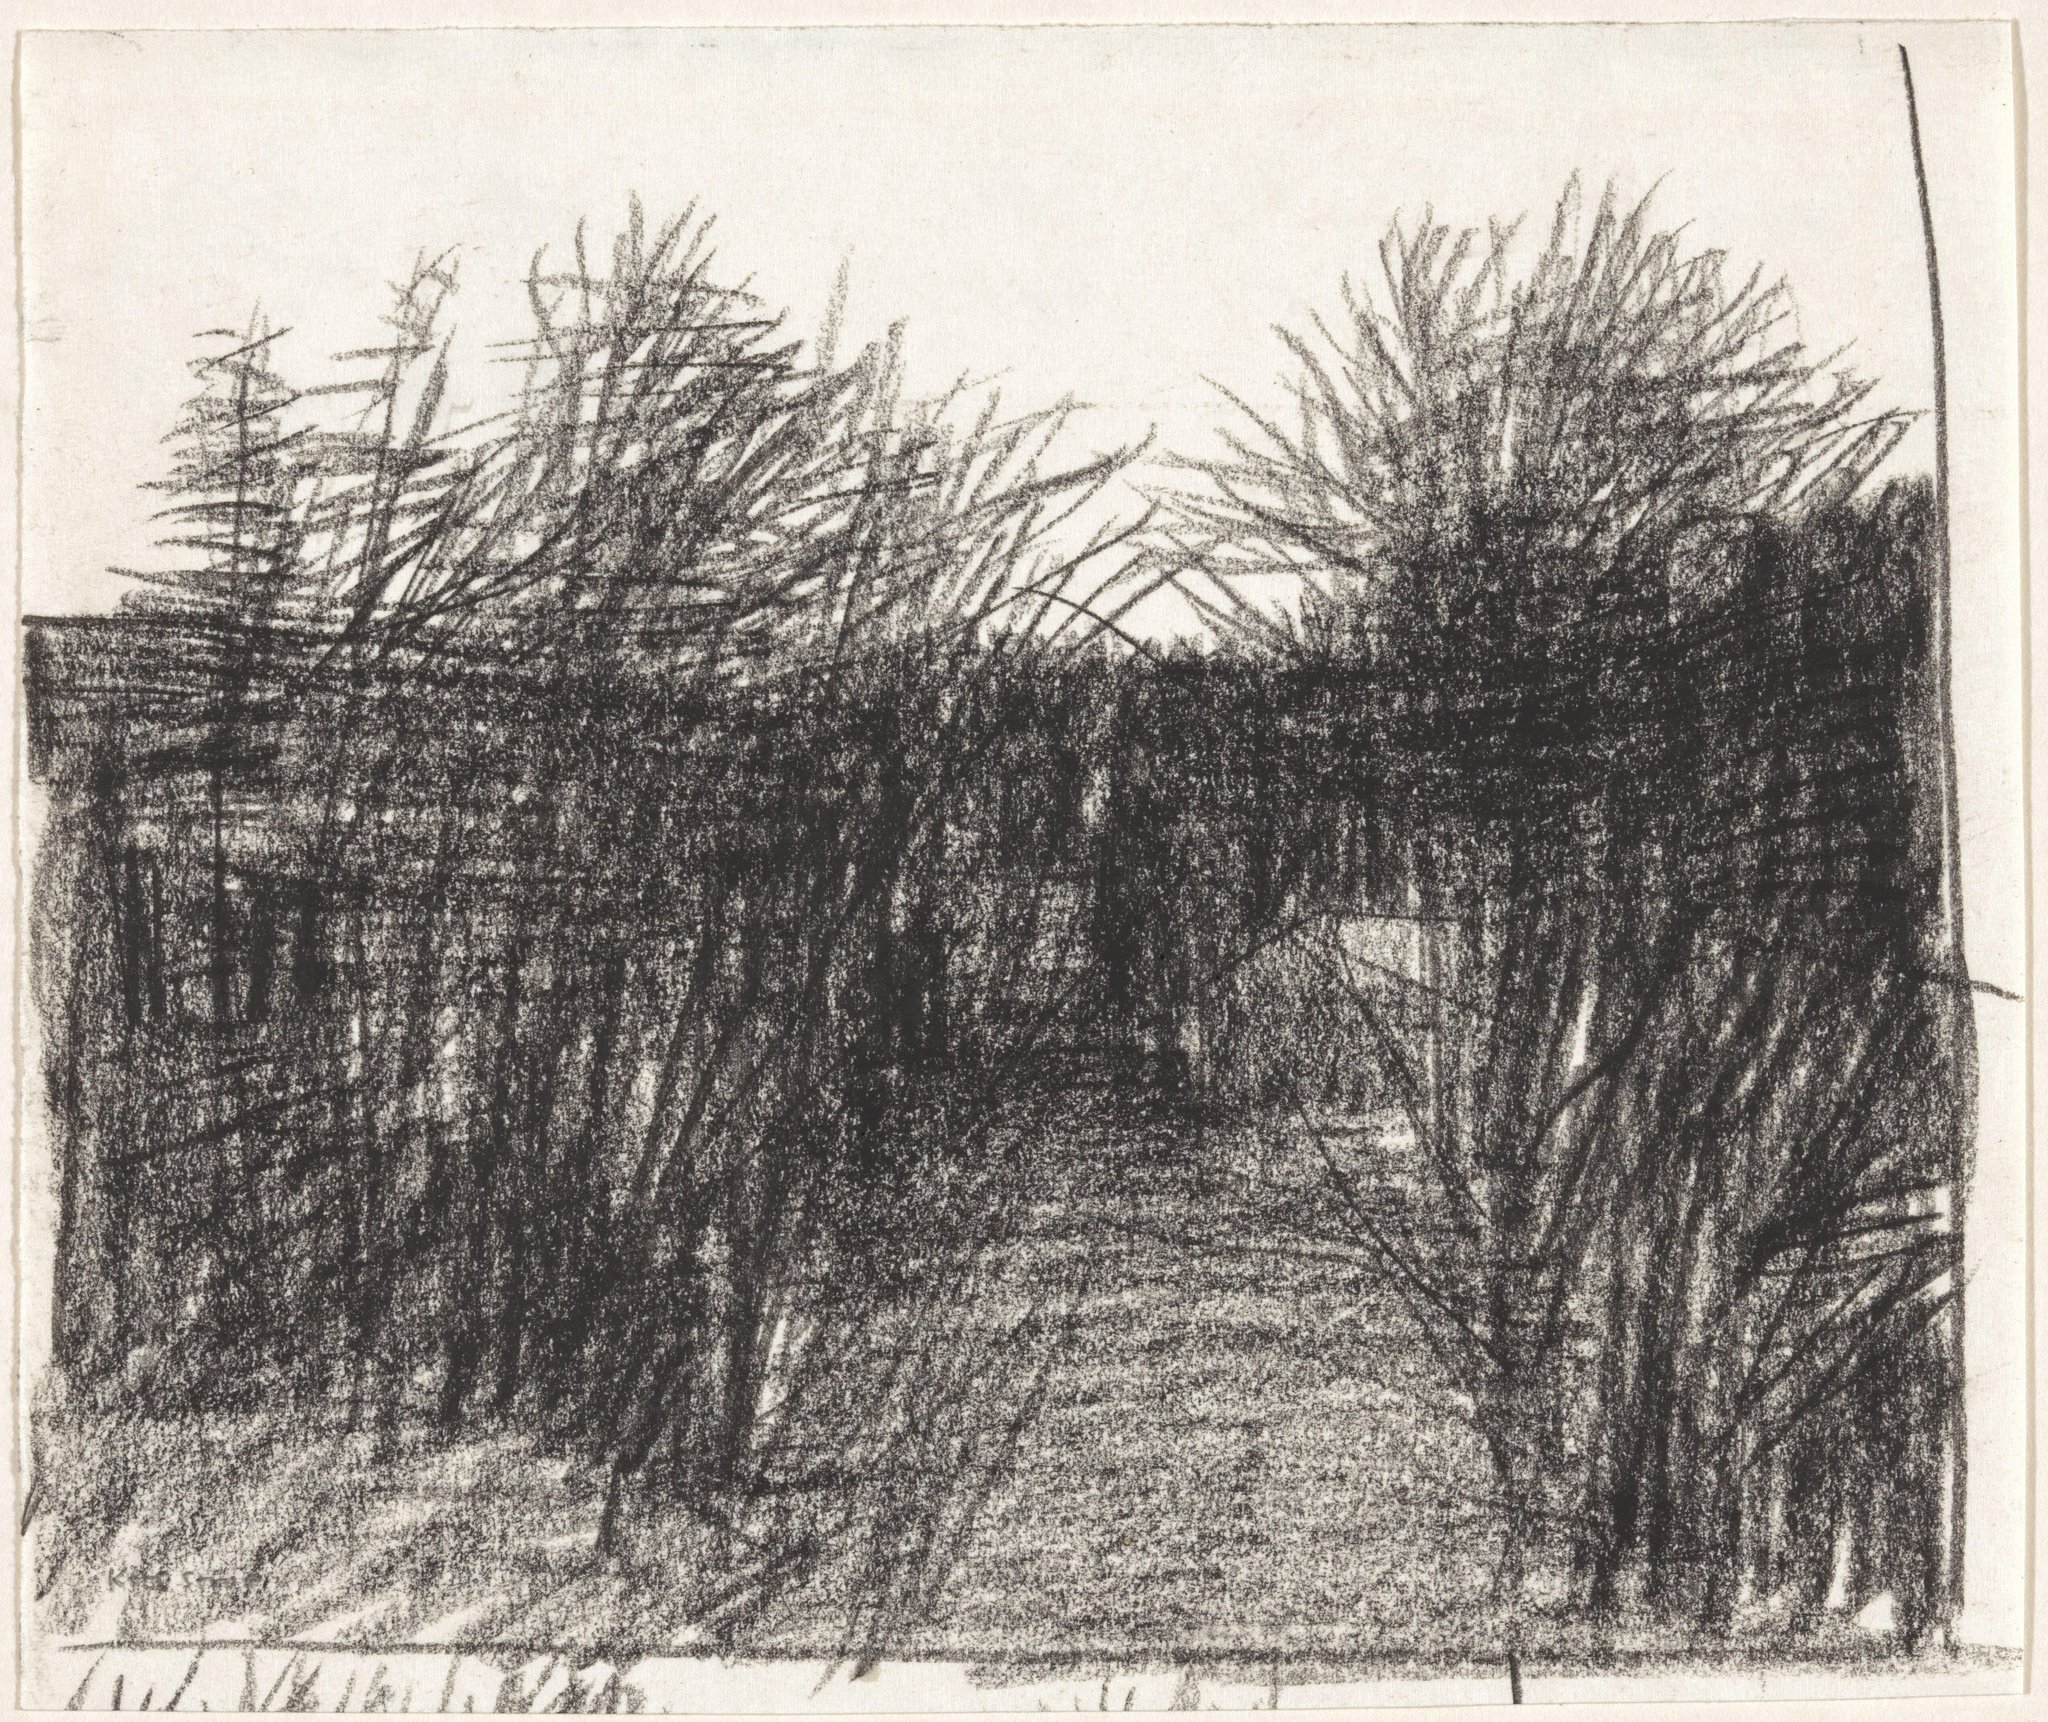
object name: drawing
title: Struikgewas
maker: kees stoop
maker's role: draughtsman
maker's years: 1929-2019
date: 1939-2009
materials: charcoal, paper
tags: bush, shrubs ~ forest